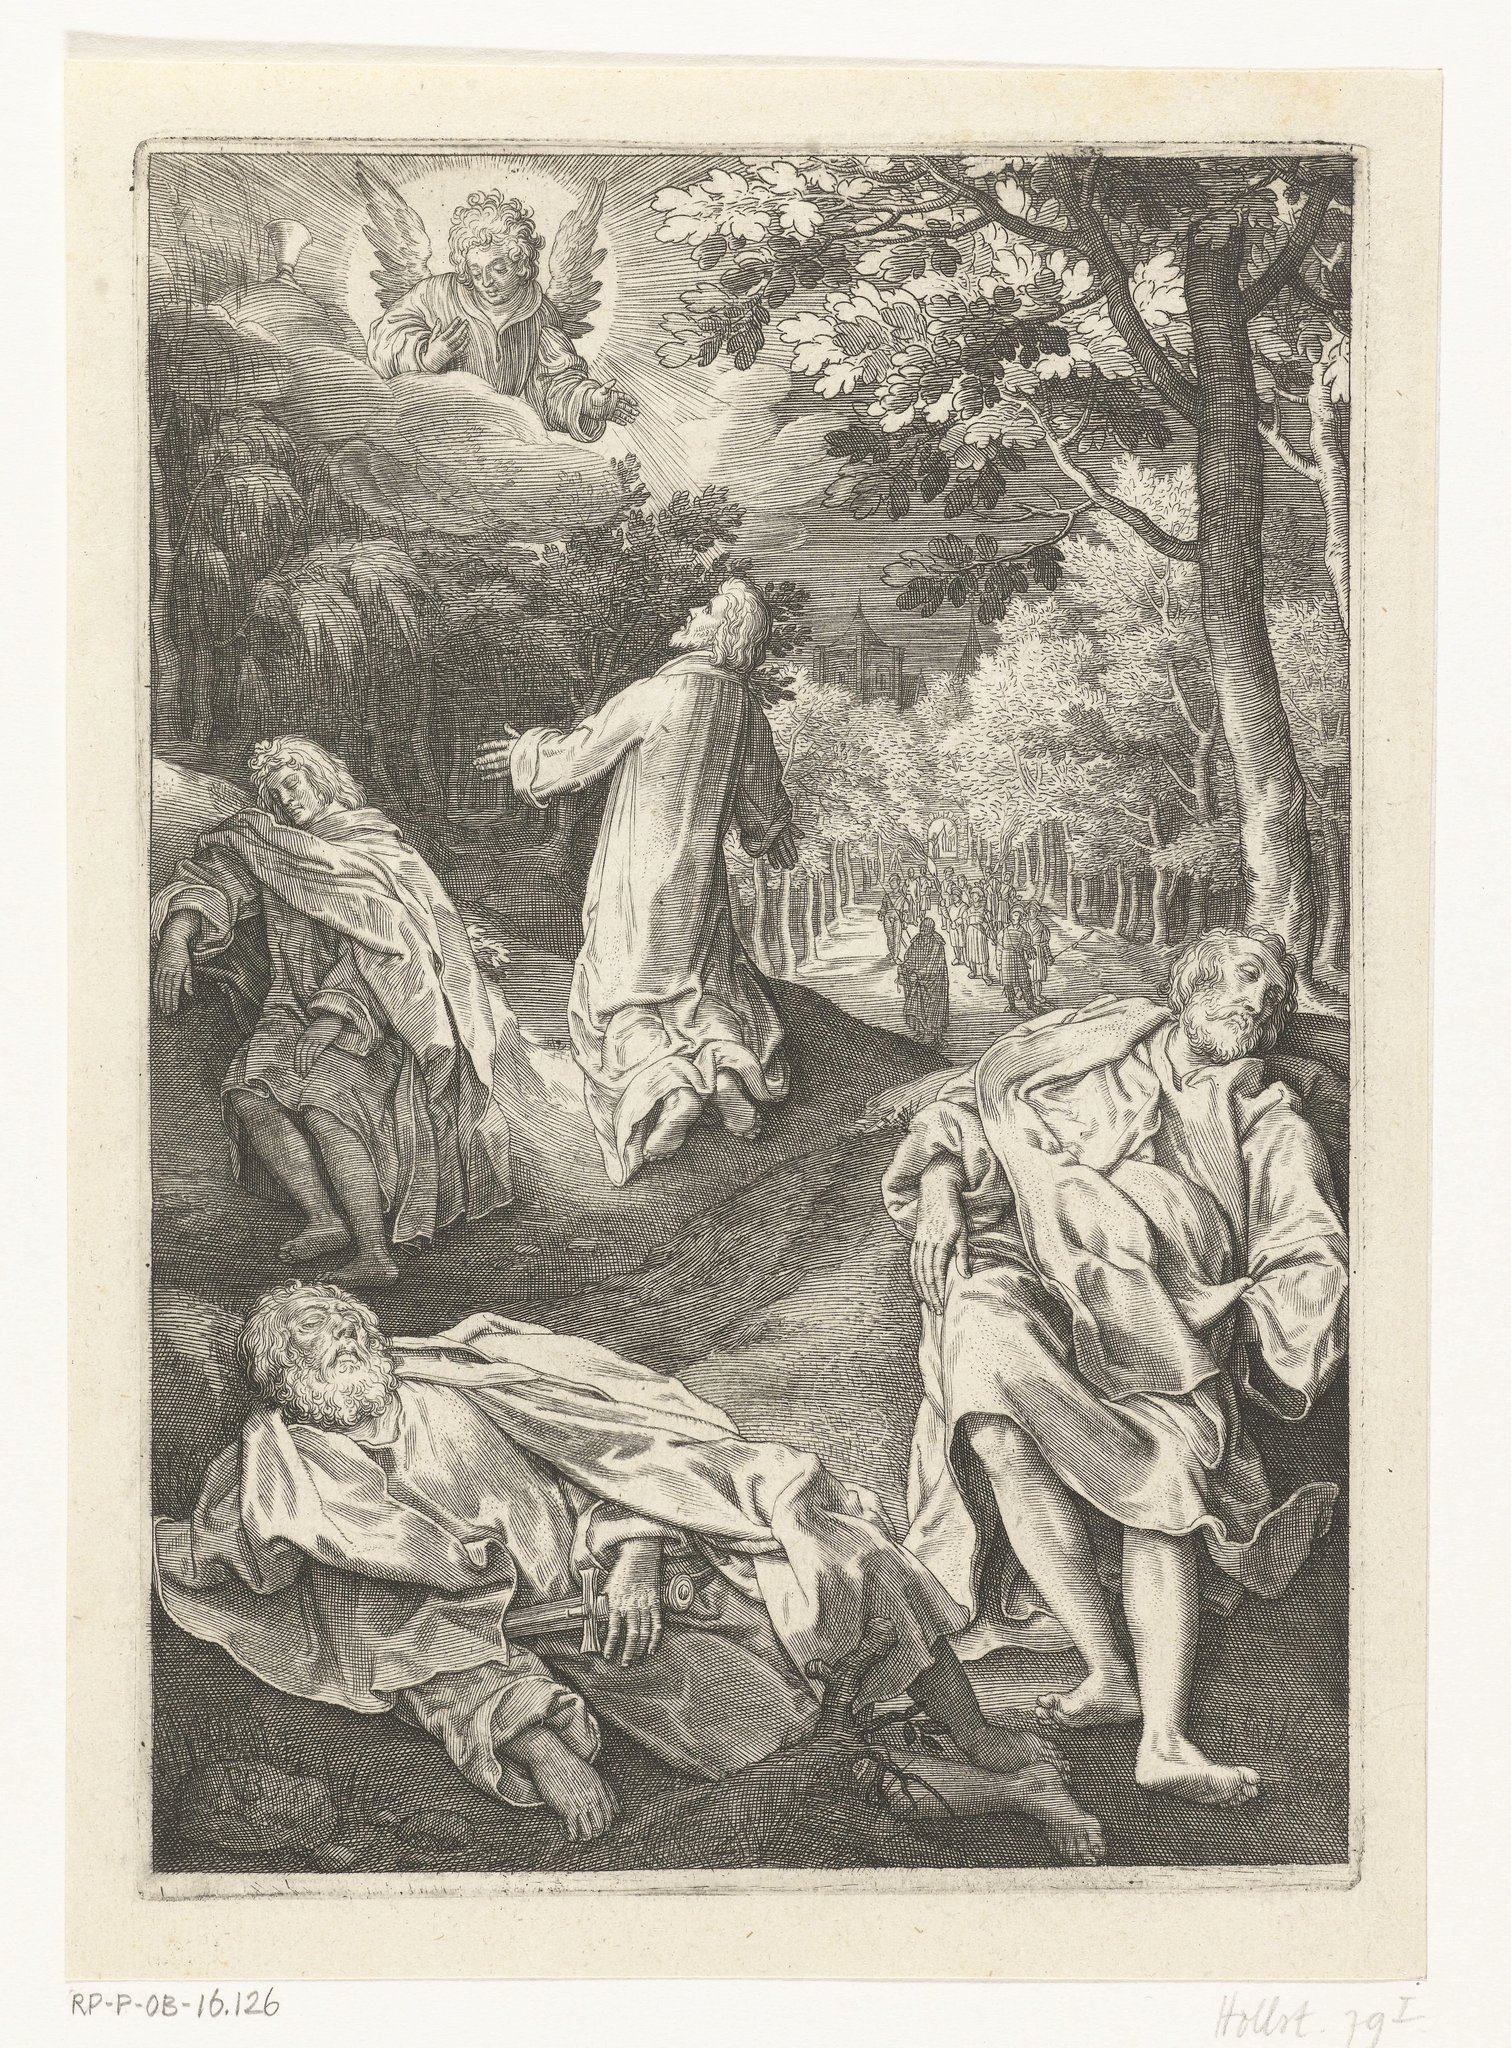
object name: print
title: Christus in de hof van Gethsemane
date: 1618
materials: paper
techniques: engraving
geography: netherlands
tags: christ's prayer in the garden of gethsemane during the night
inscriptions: date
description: Een engel verschijnt voor Christus op de Olijfberg om hem kracht te geven. Christus knielt in gebed en kijkt omhoog, hij wordt omringd door zijn slapende discipelen Petrus, Jakobus en Johannes.